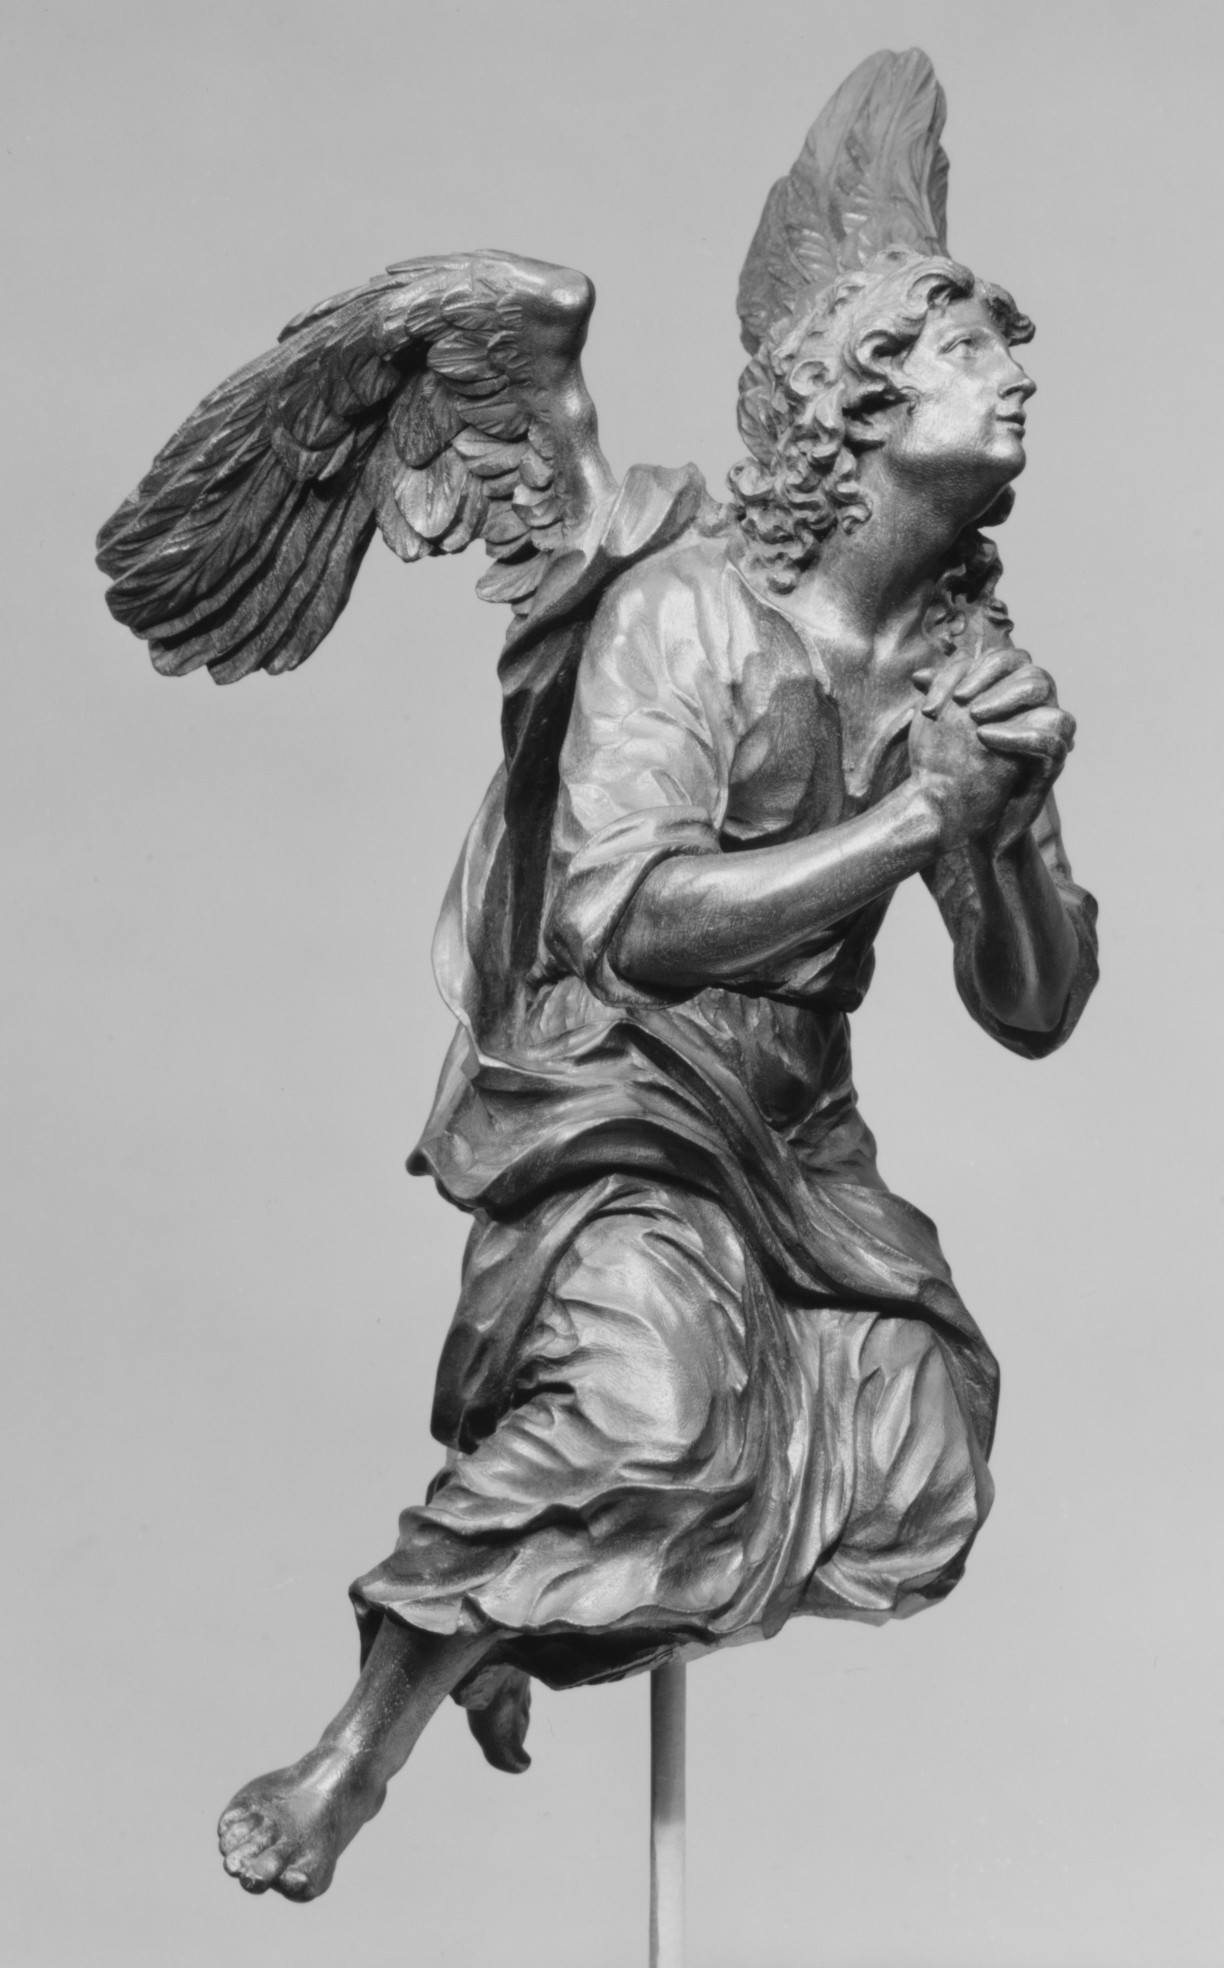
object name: angel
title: Angel (one of a pair)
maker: hendrik-frans verbruggen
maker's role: artist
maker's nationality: flemish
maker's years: 1654-1724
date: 1690-1710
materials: wood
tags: angels